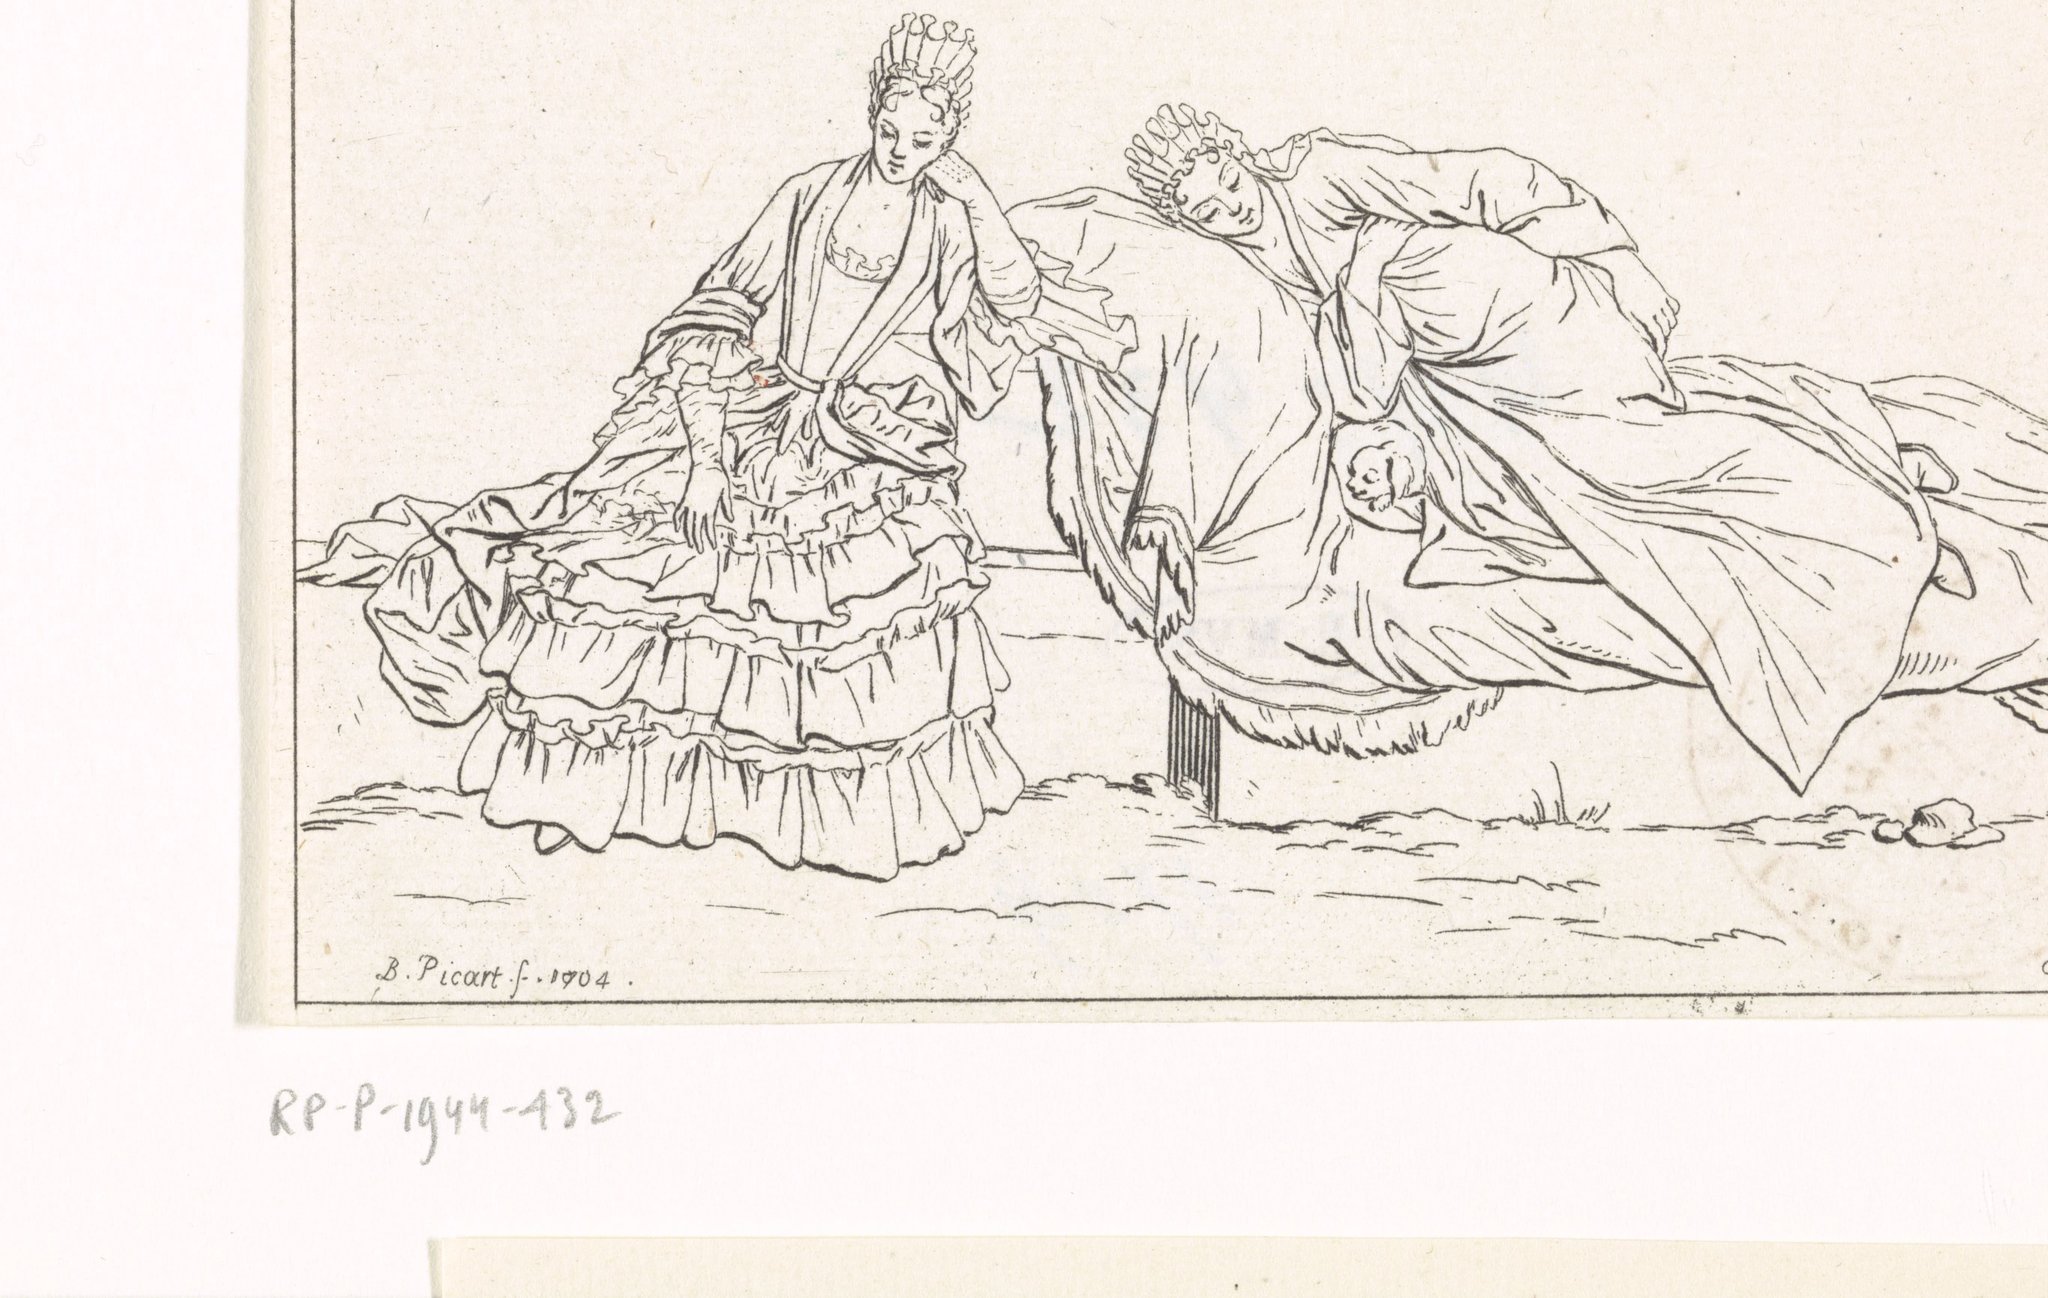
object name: print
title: Manier waarop vrouwen rusten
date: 1704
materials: paper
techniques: etching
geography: paris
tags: sleeping; unconsciousness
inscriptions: collector's mark: Lugt 2228, collector's mark: Lugt 240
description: Een vrouw rust op een ligbed met haar hondje. De ander leunt er tegen aan. Ze dragen eigentijdse kleding.